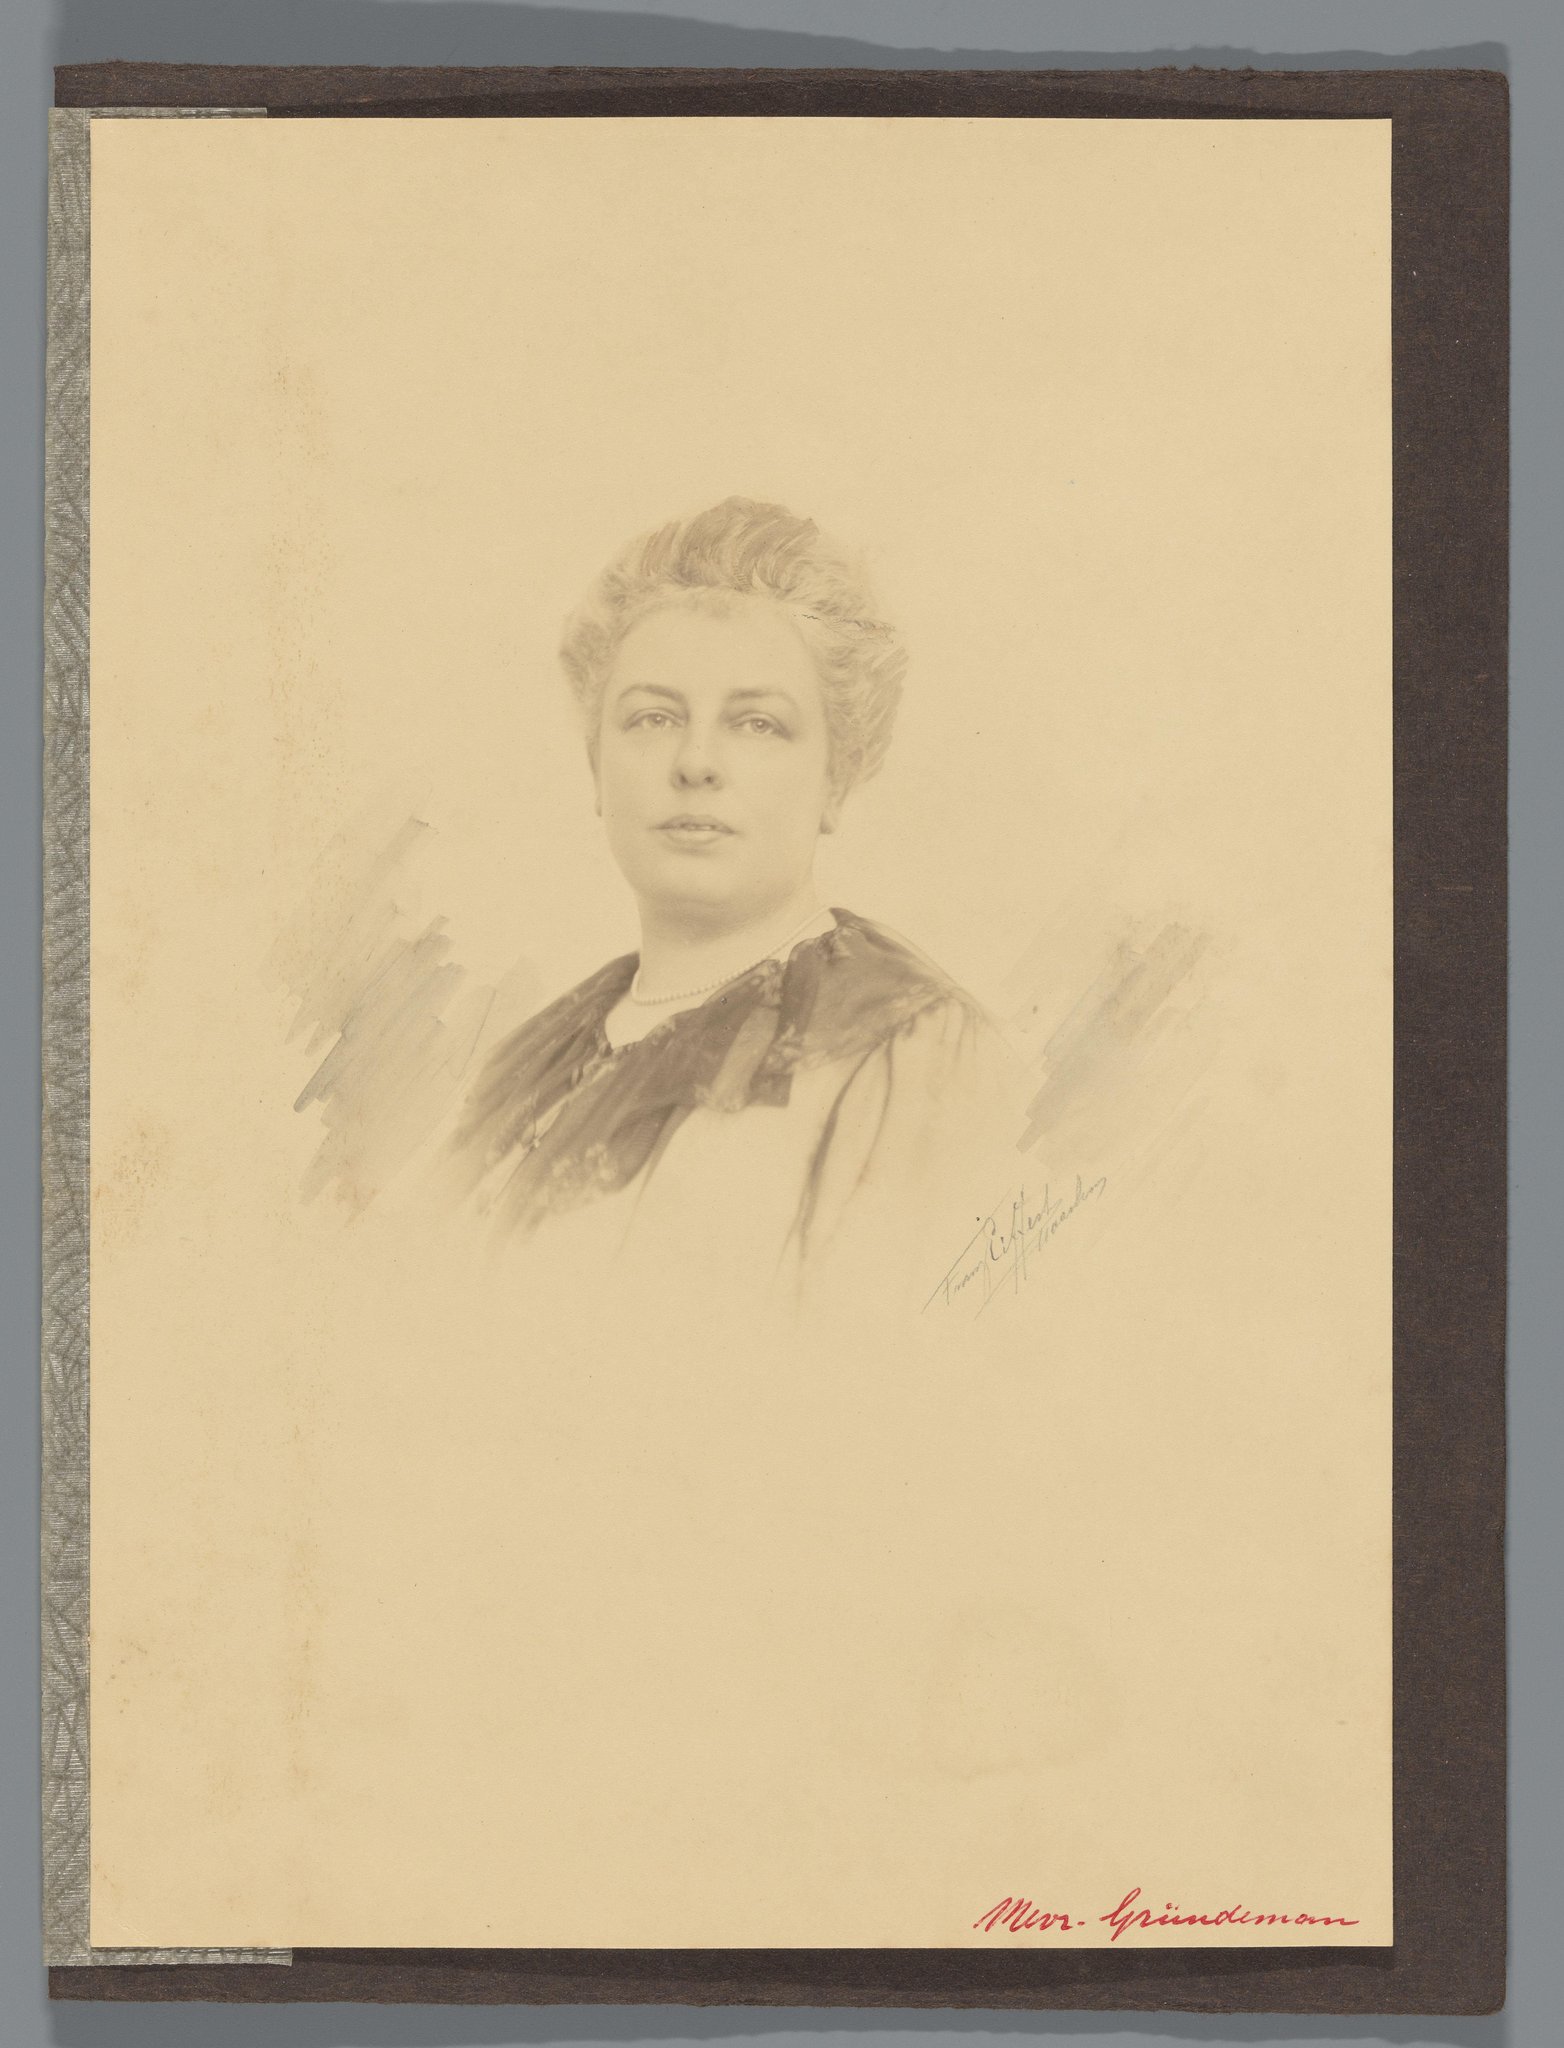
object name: photograph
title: Portret van een onbekende vrouw, aangeduid als mevrouw Gründeman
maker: franz eiffert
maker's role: fotograaf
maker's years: 1866-1929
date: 1915-1925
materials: paper, cardboard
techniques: gelatin silver print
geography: the hague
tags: historical persons - bb - woman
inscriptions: inscription: ‘Mevr. Gründeman’